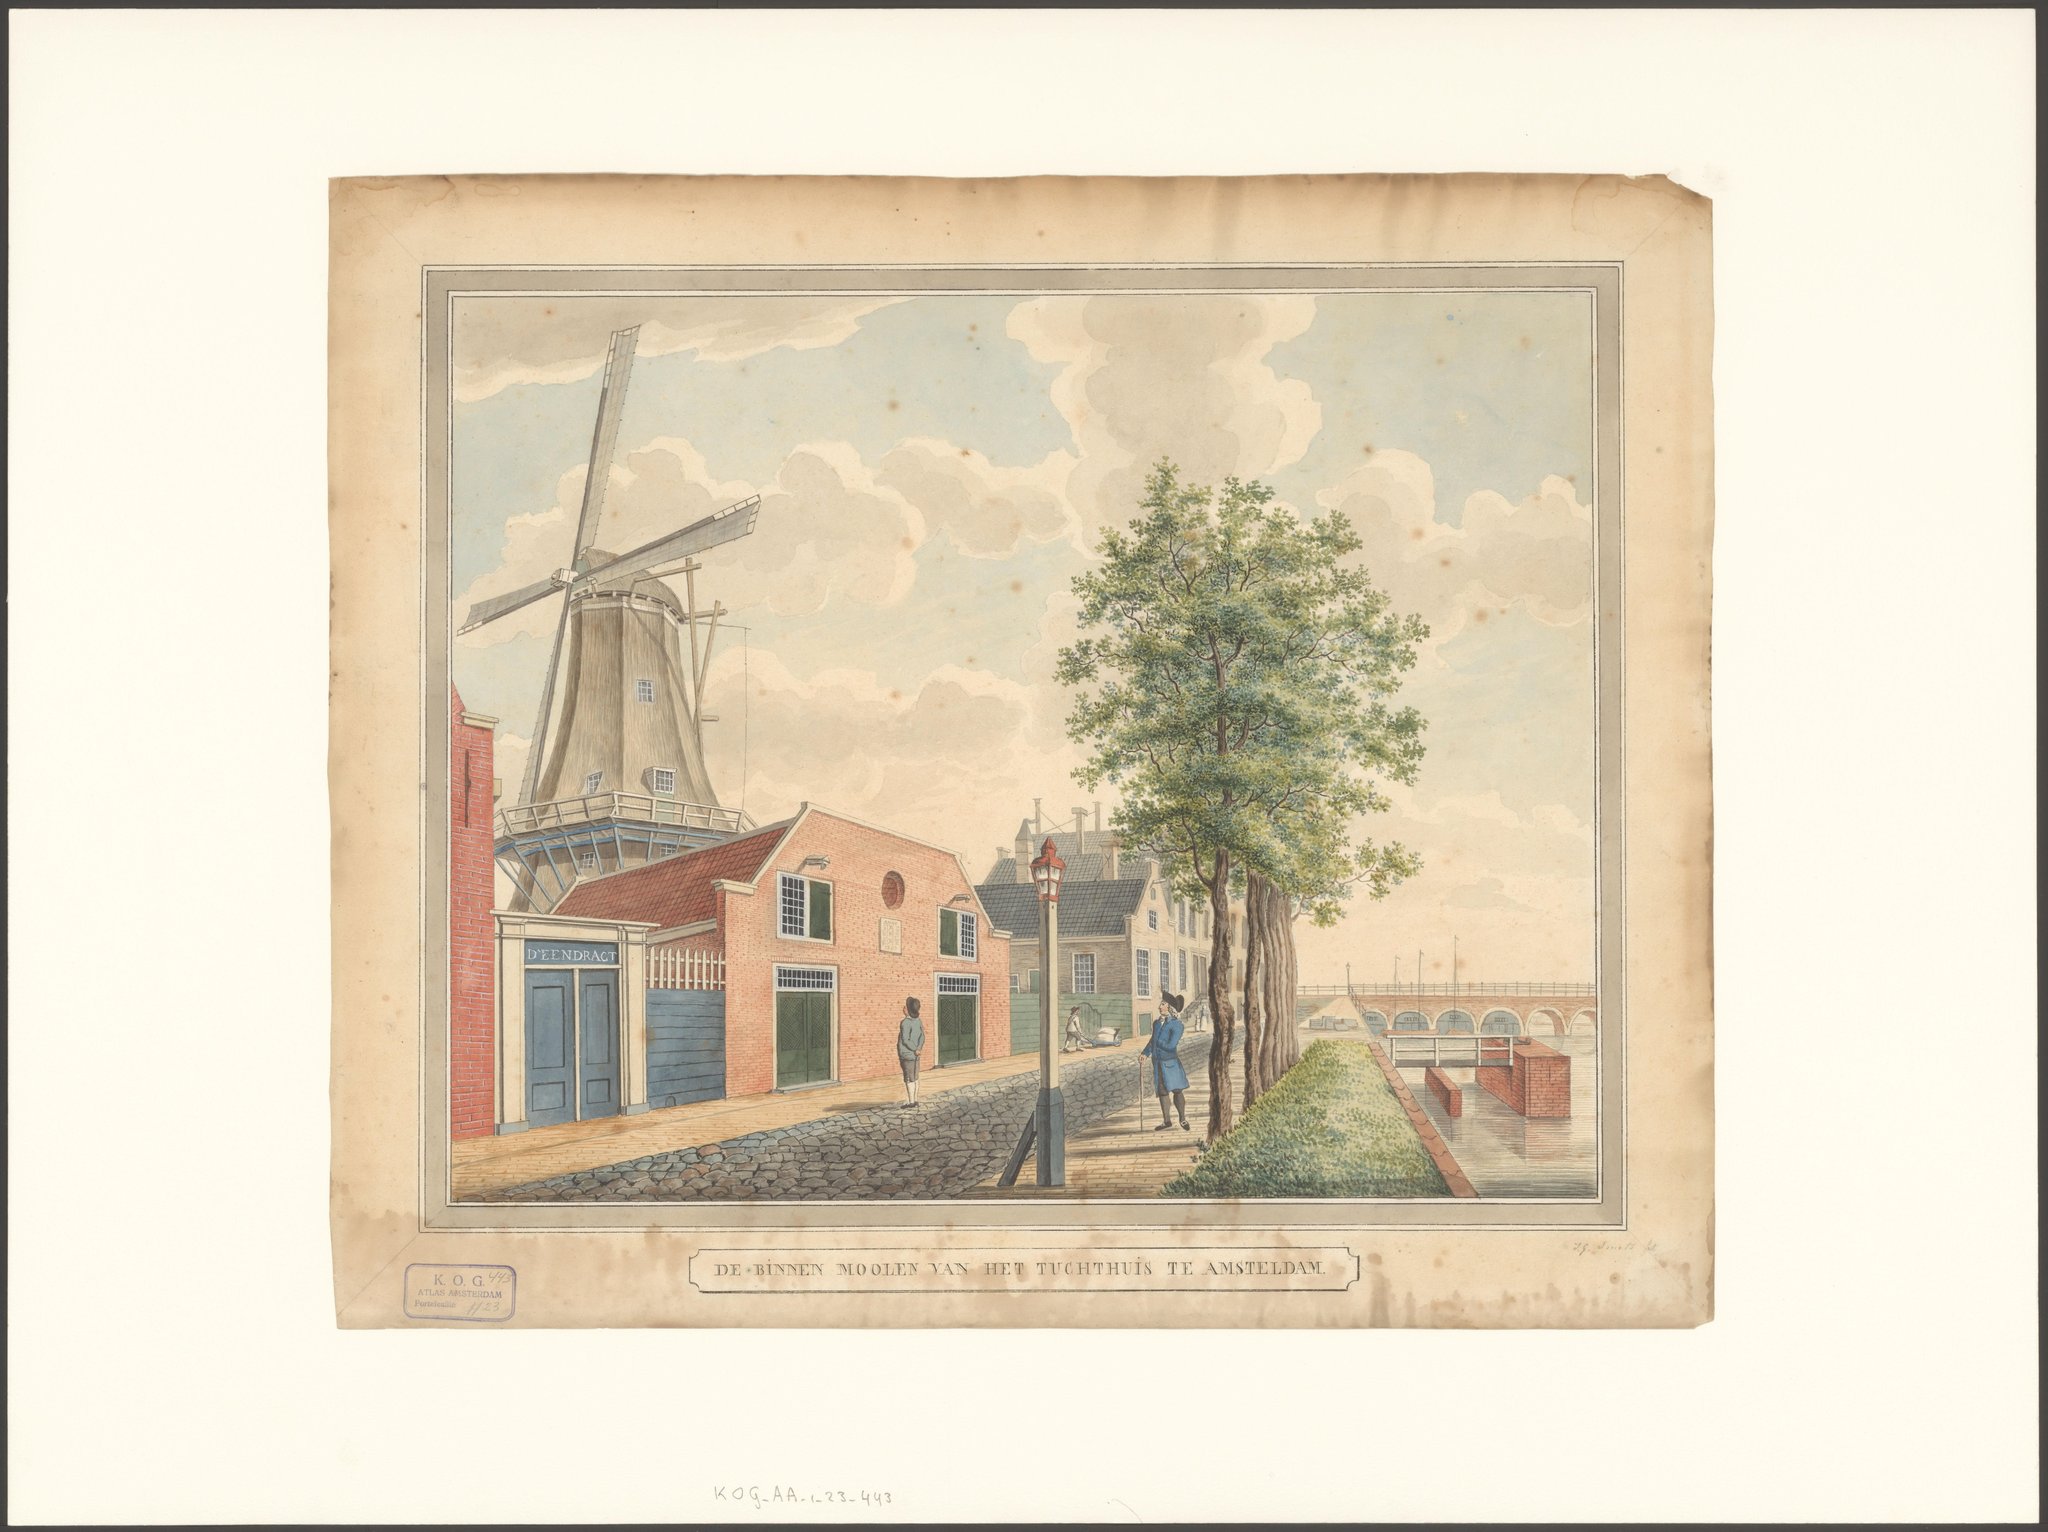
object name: drawing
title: Gezicht op molen De Eendragt bij het tuchthuis aan de Kostverlorenvaart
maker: jan gerard smits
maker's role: draughtsman, print maker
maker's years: 1823-1910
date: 1838-1895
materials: paint, gouache, ink, paper, pencil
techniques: brush, pen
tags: city-view in general; 'veduta', canal, windmill in landscape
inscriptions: inscription: ‘De Binnen Moolen van het Tuchthuis te Amsteldam’, collector's mark: ‘#23 / 443’ Lugt 1641b, inscription: ‘Port. 23-443’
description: Onderwerpsrubriek binnen de Atlas Amsterdam: Handvesten, Keuren, enz.; Rechtswezen (incl. gevangenissen, enz.).